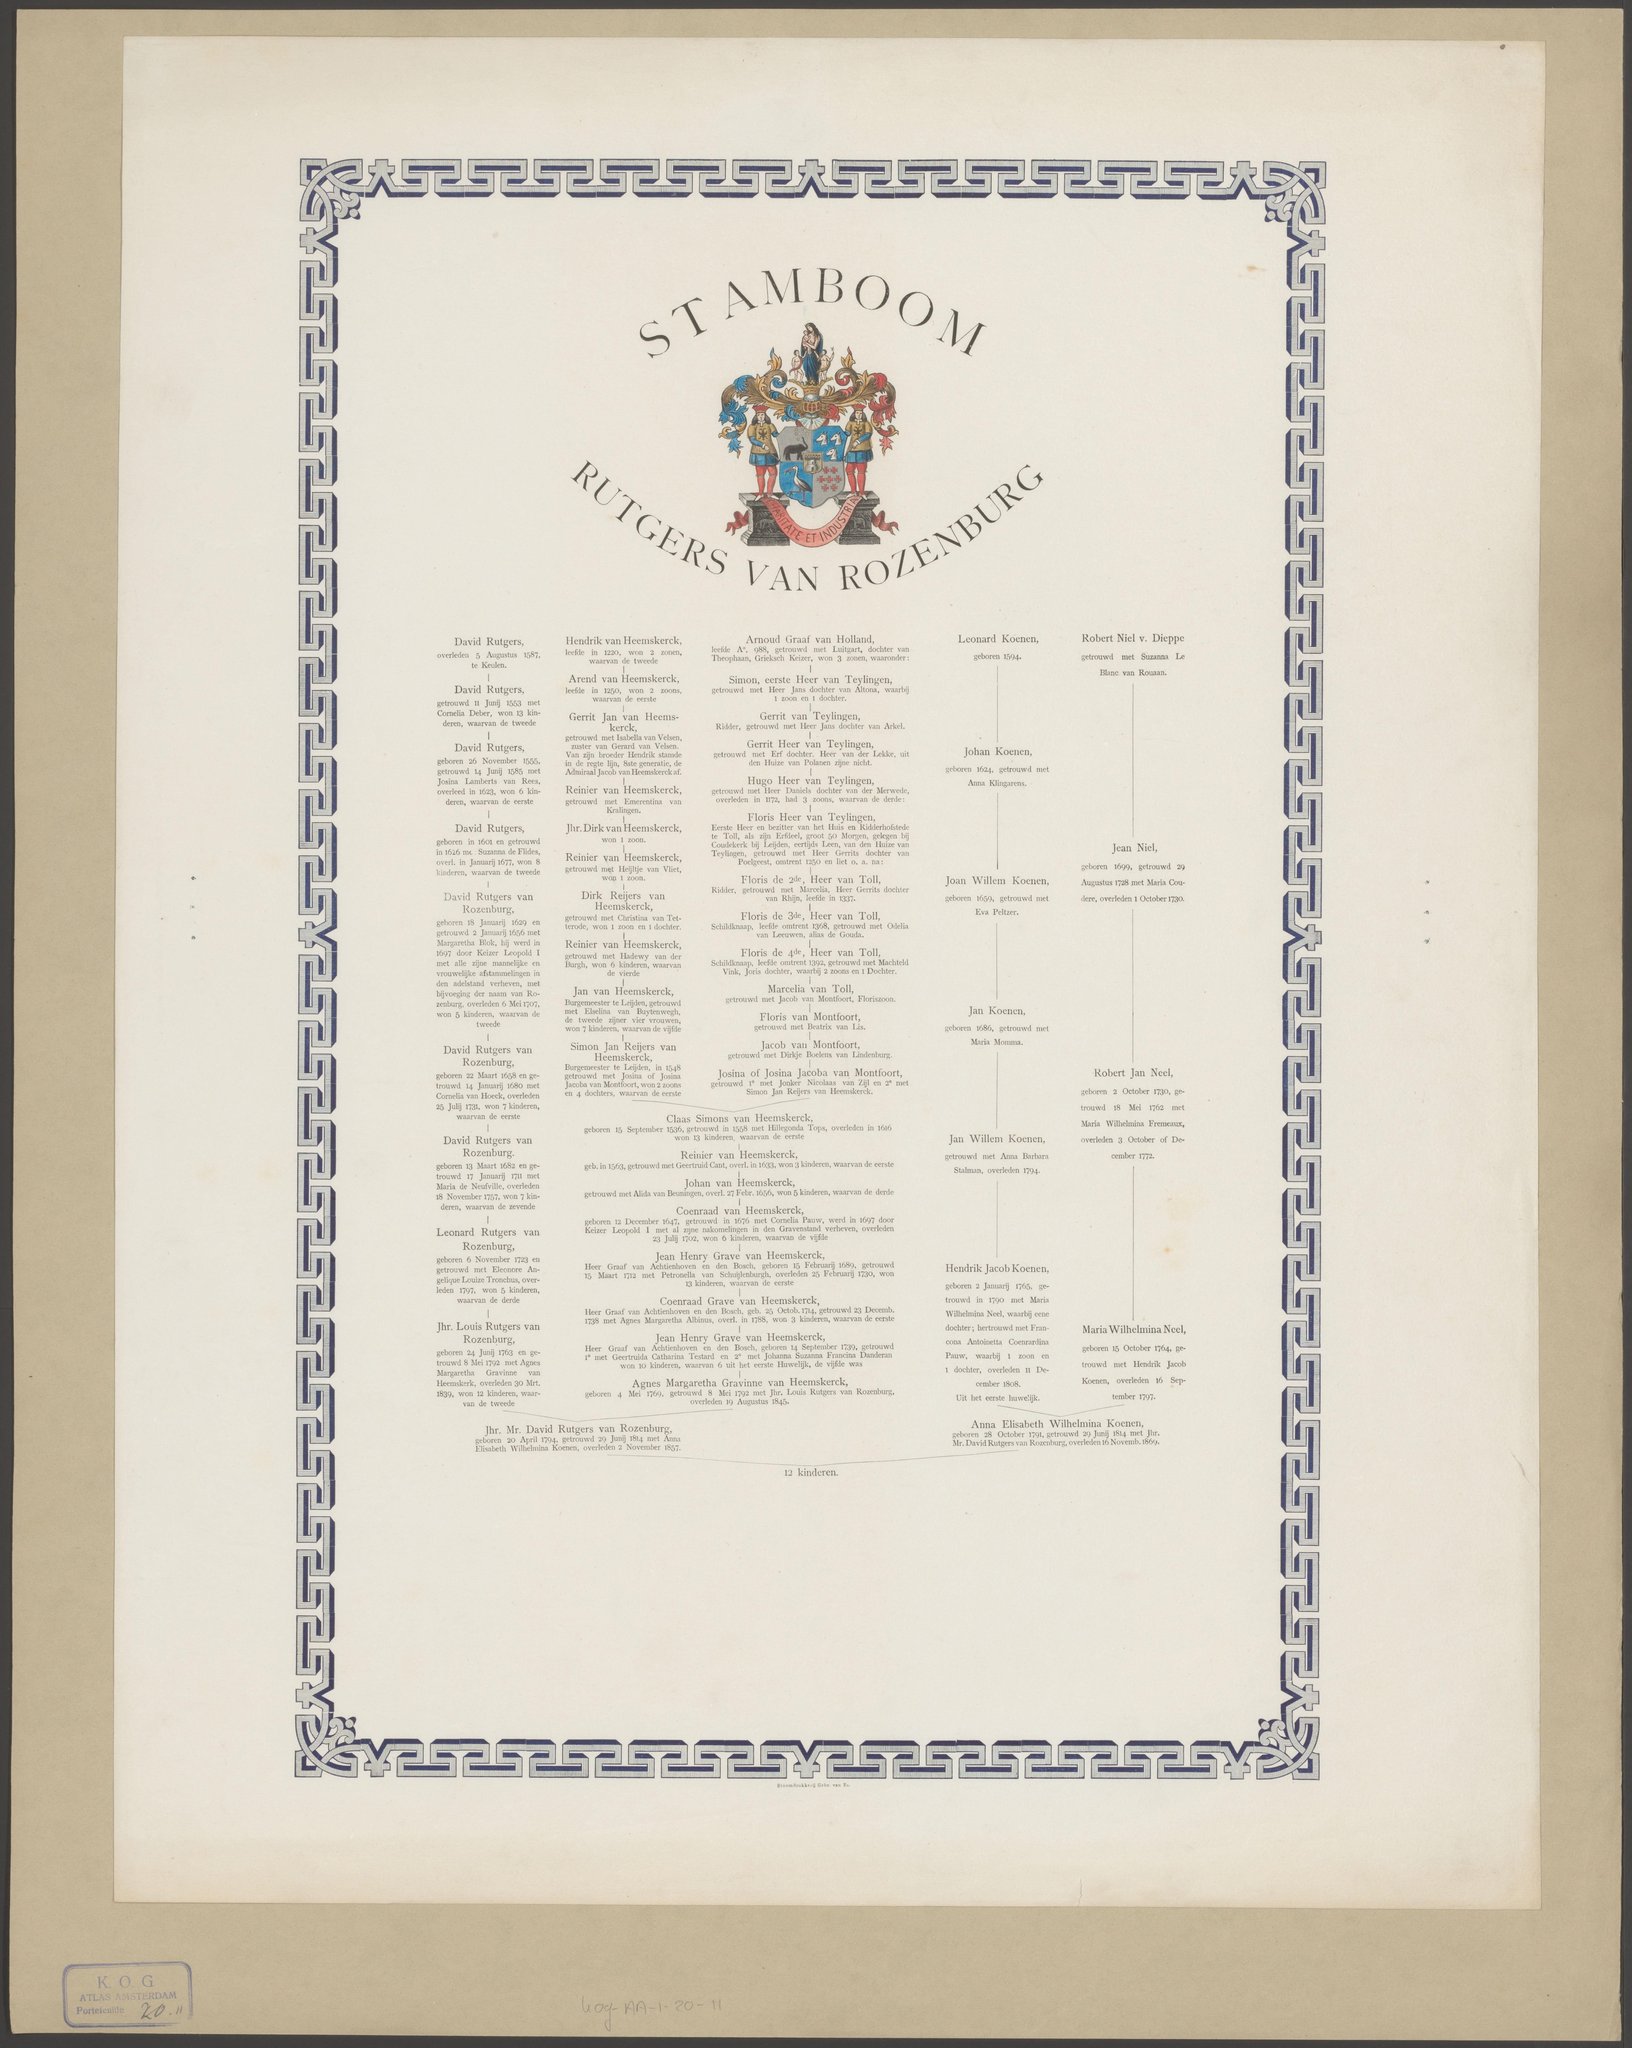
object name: print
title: Stamboom van de familie Rutgers van Rozenburg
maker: Anonymous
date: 1869-1899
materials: paper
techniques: hand coloring, letterpress printing, engraving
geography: amsterdam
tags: armorial bearing, heraldry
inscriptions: collector's mark: Lugt 1641b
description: Onderwerpsrubriek binnen de Atlas Amsterdam: Wapens regeringsleden.